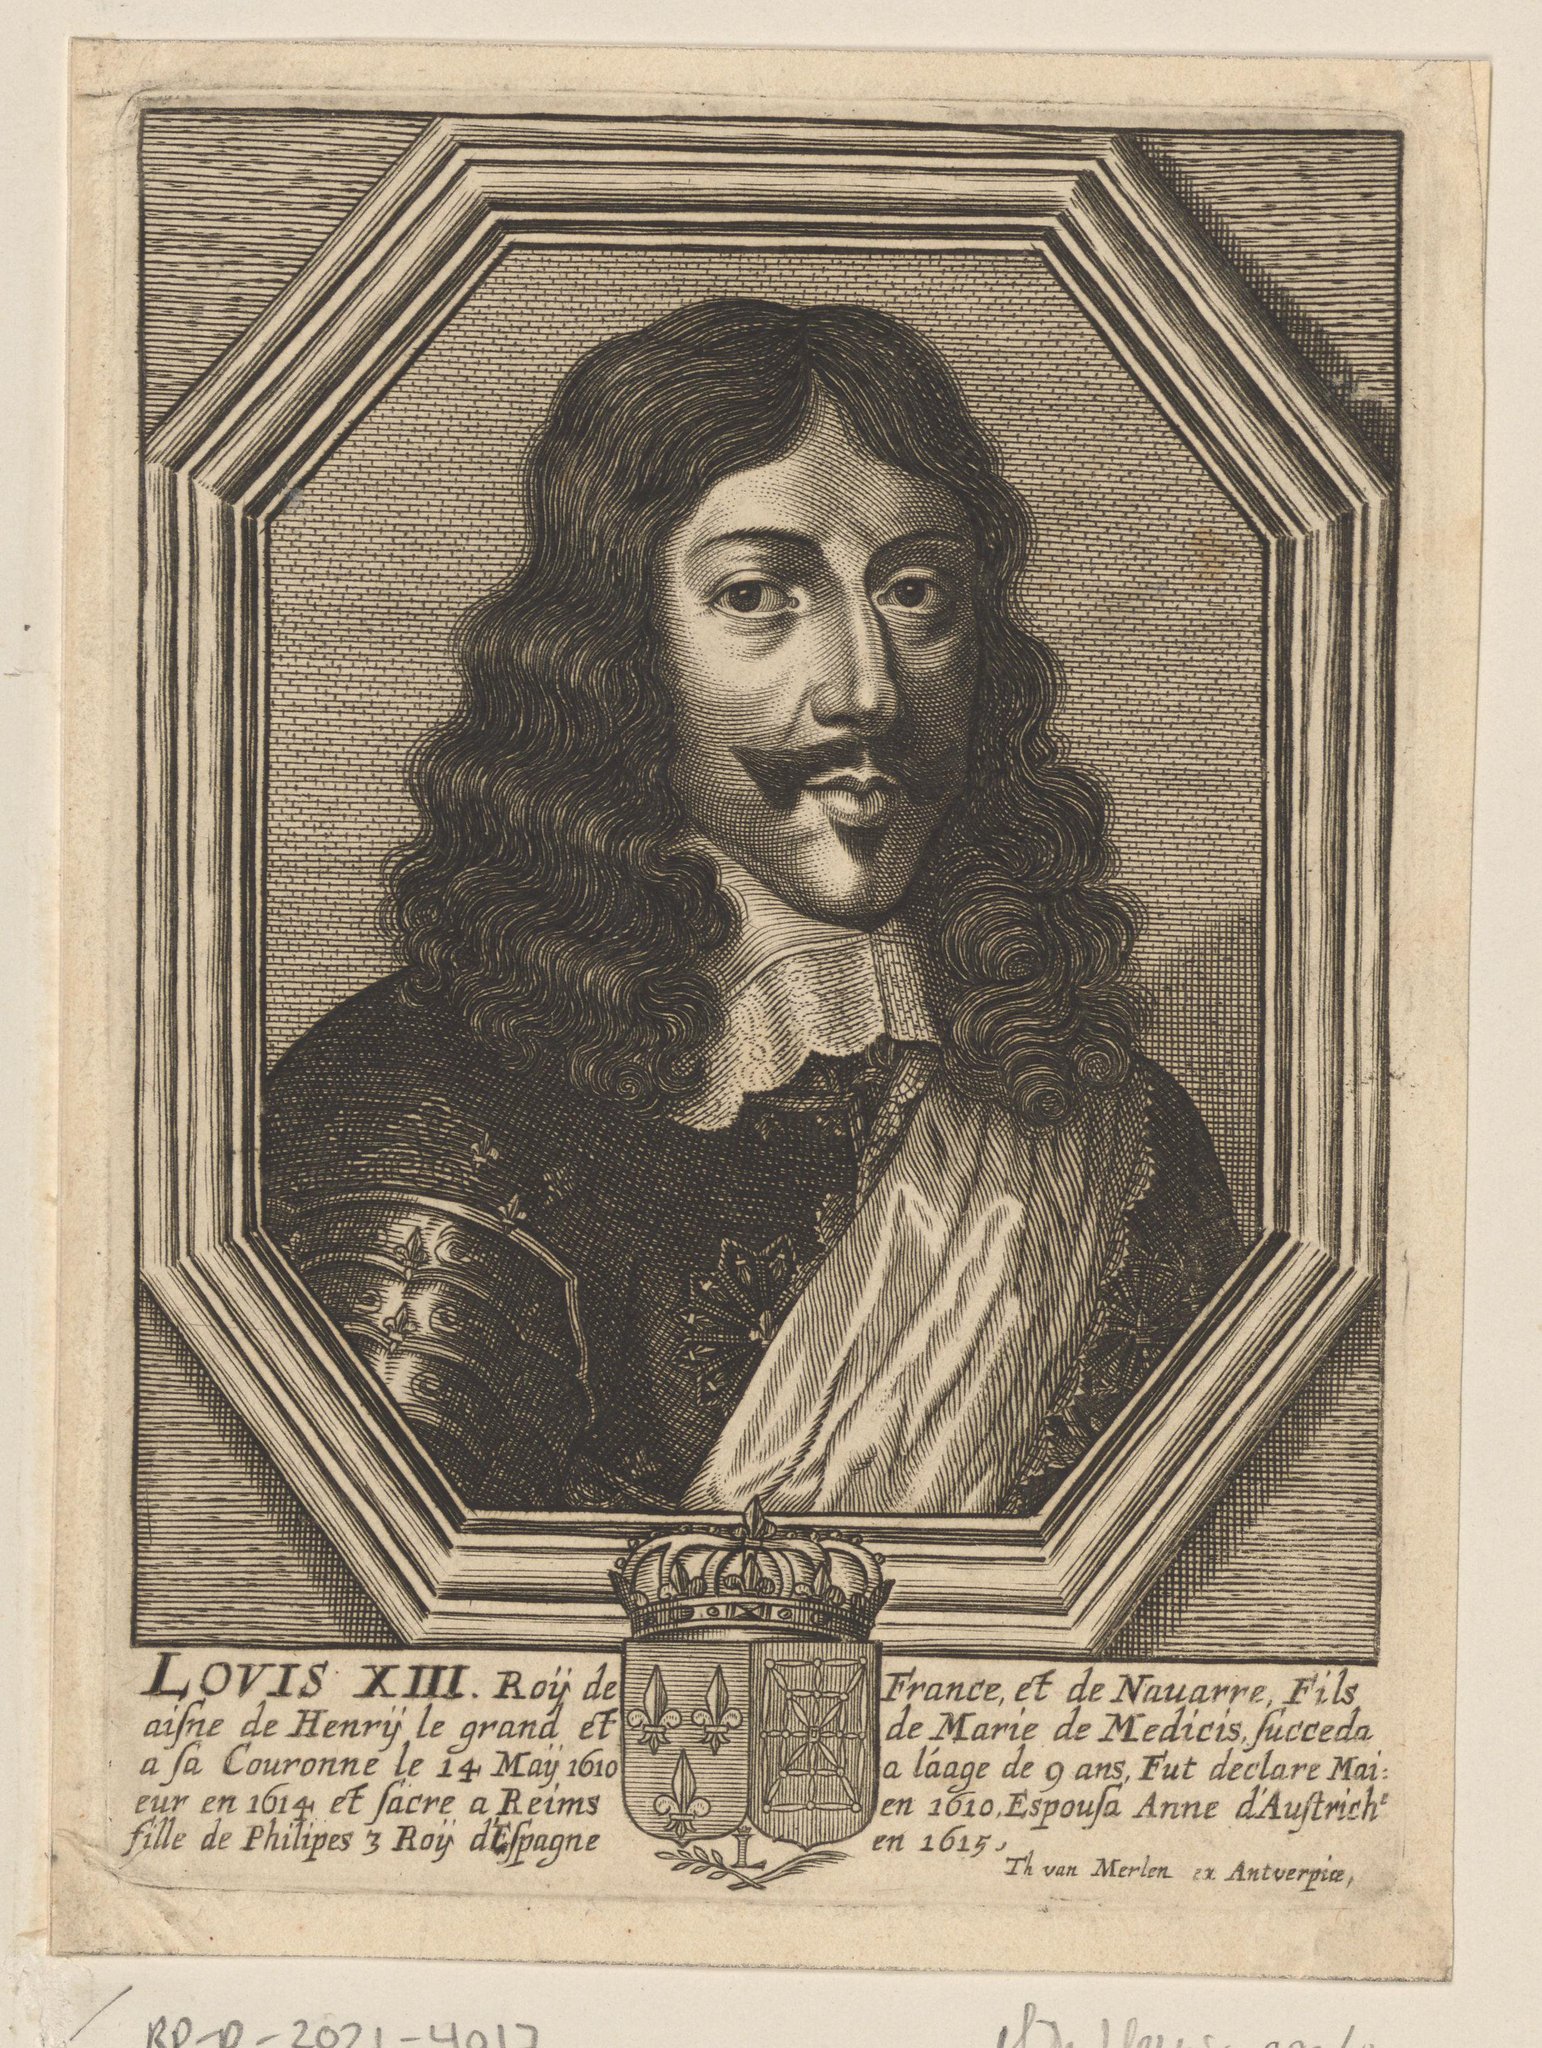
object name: print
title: Portret van Lodewijk XIII van Frankrijk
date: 1629-1672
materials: paper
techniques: engraving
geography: antwerp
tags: lodewijk xiii (koning van frankrijk), armour, historical persons, king, armorial bearing, heraldry